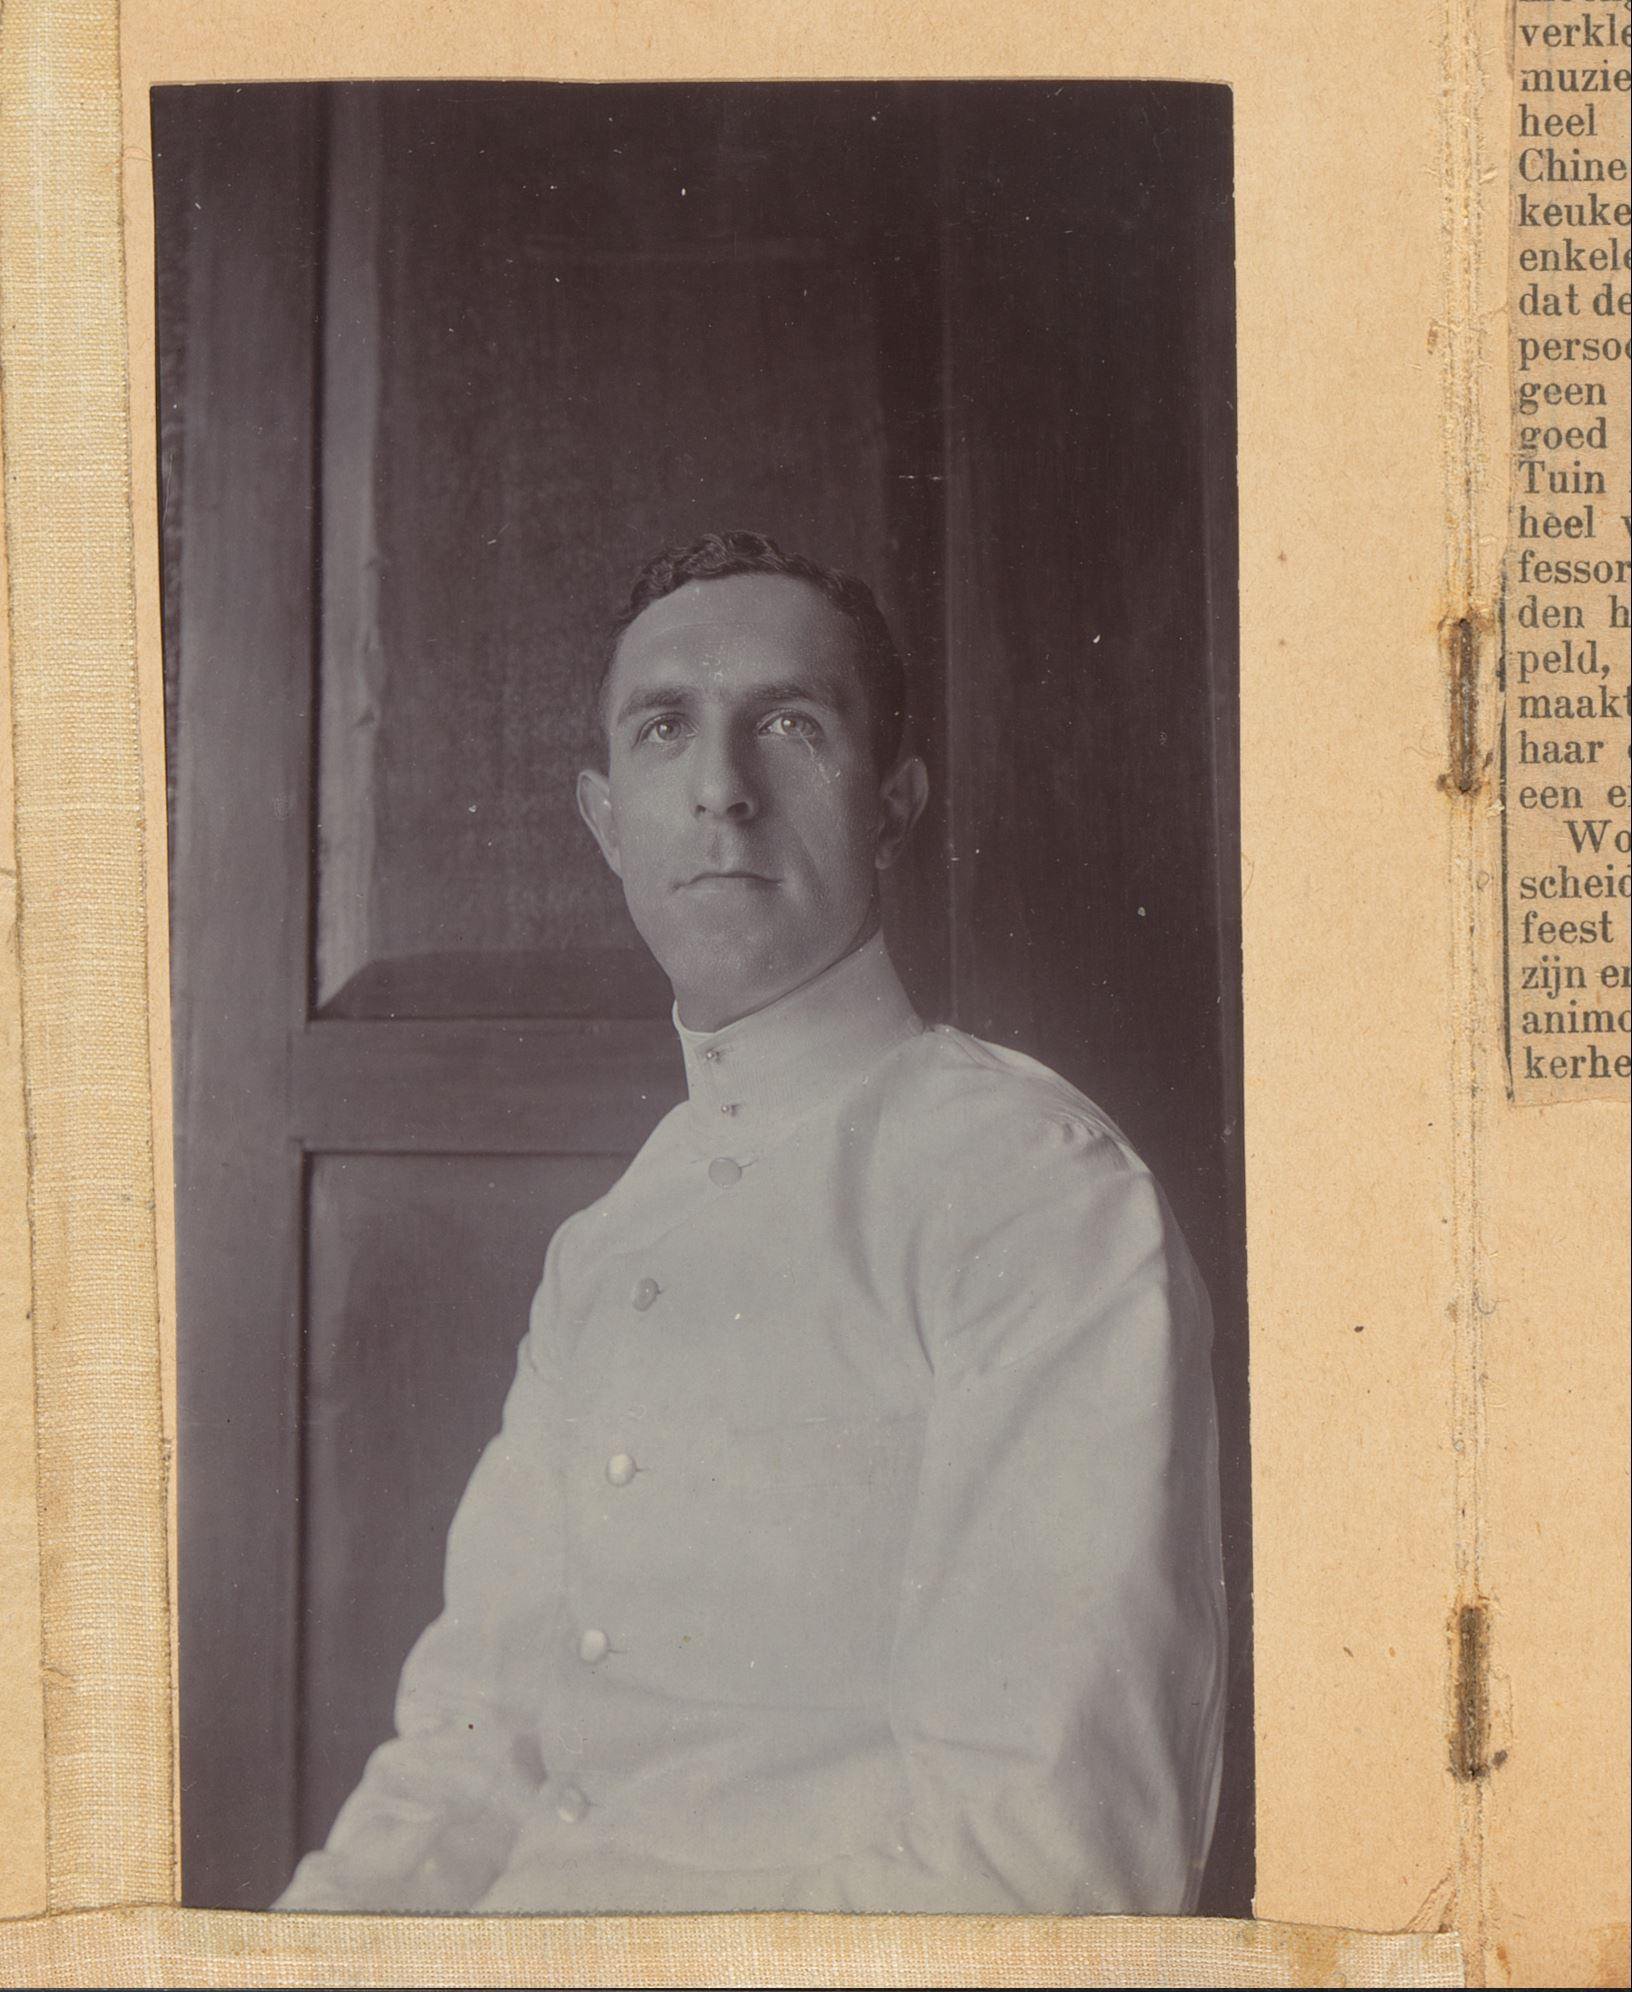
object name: photograph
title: Portret van een zittende man in tropenkleding in Nederlands-Indië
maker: Anonymous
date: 1917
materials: photographic support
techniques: gelatin silver print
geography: dutch east indies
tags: adult man, dutch east indies, the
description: Onderdeel van Familiealbum met foto's van een familie in de voormalige kolonie Nederlands-Indië en van een suikerfabriek in Purworejo.